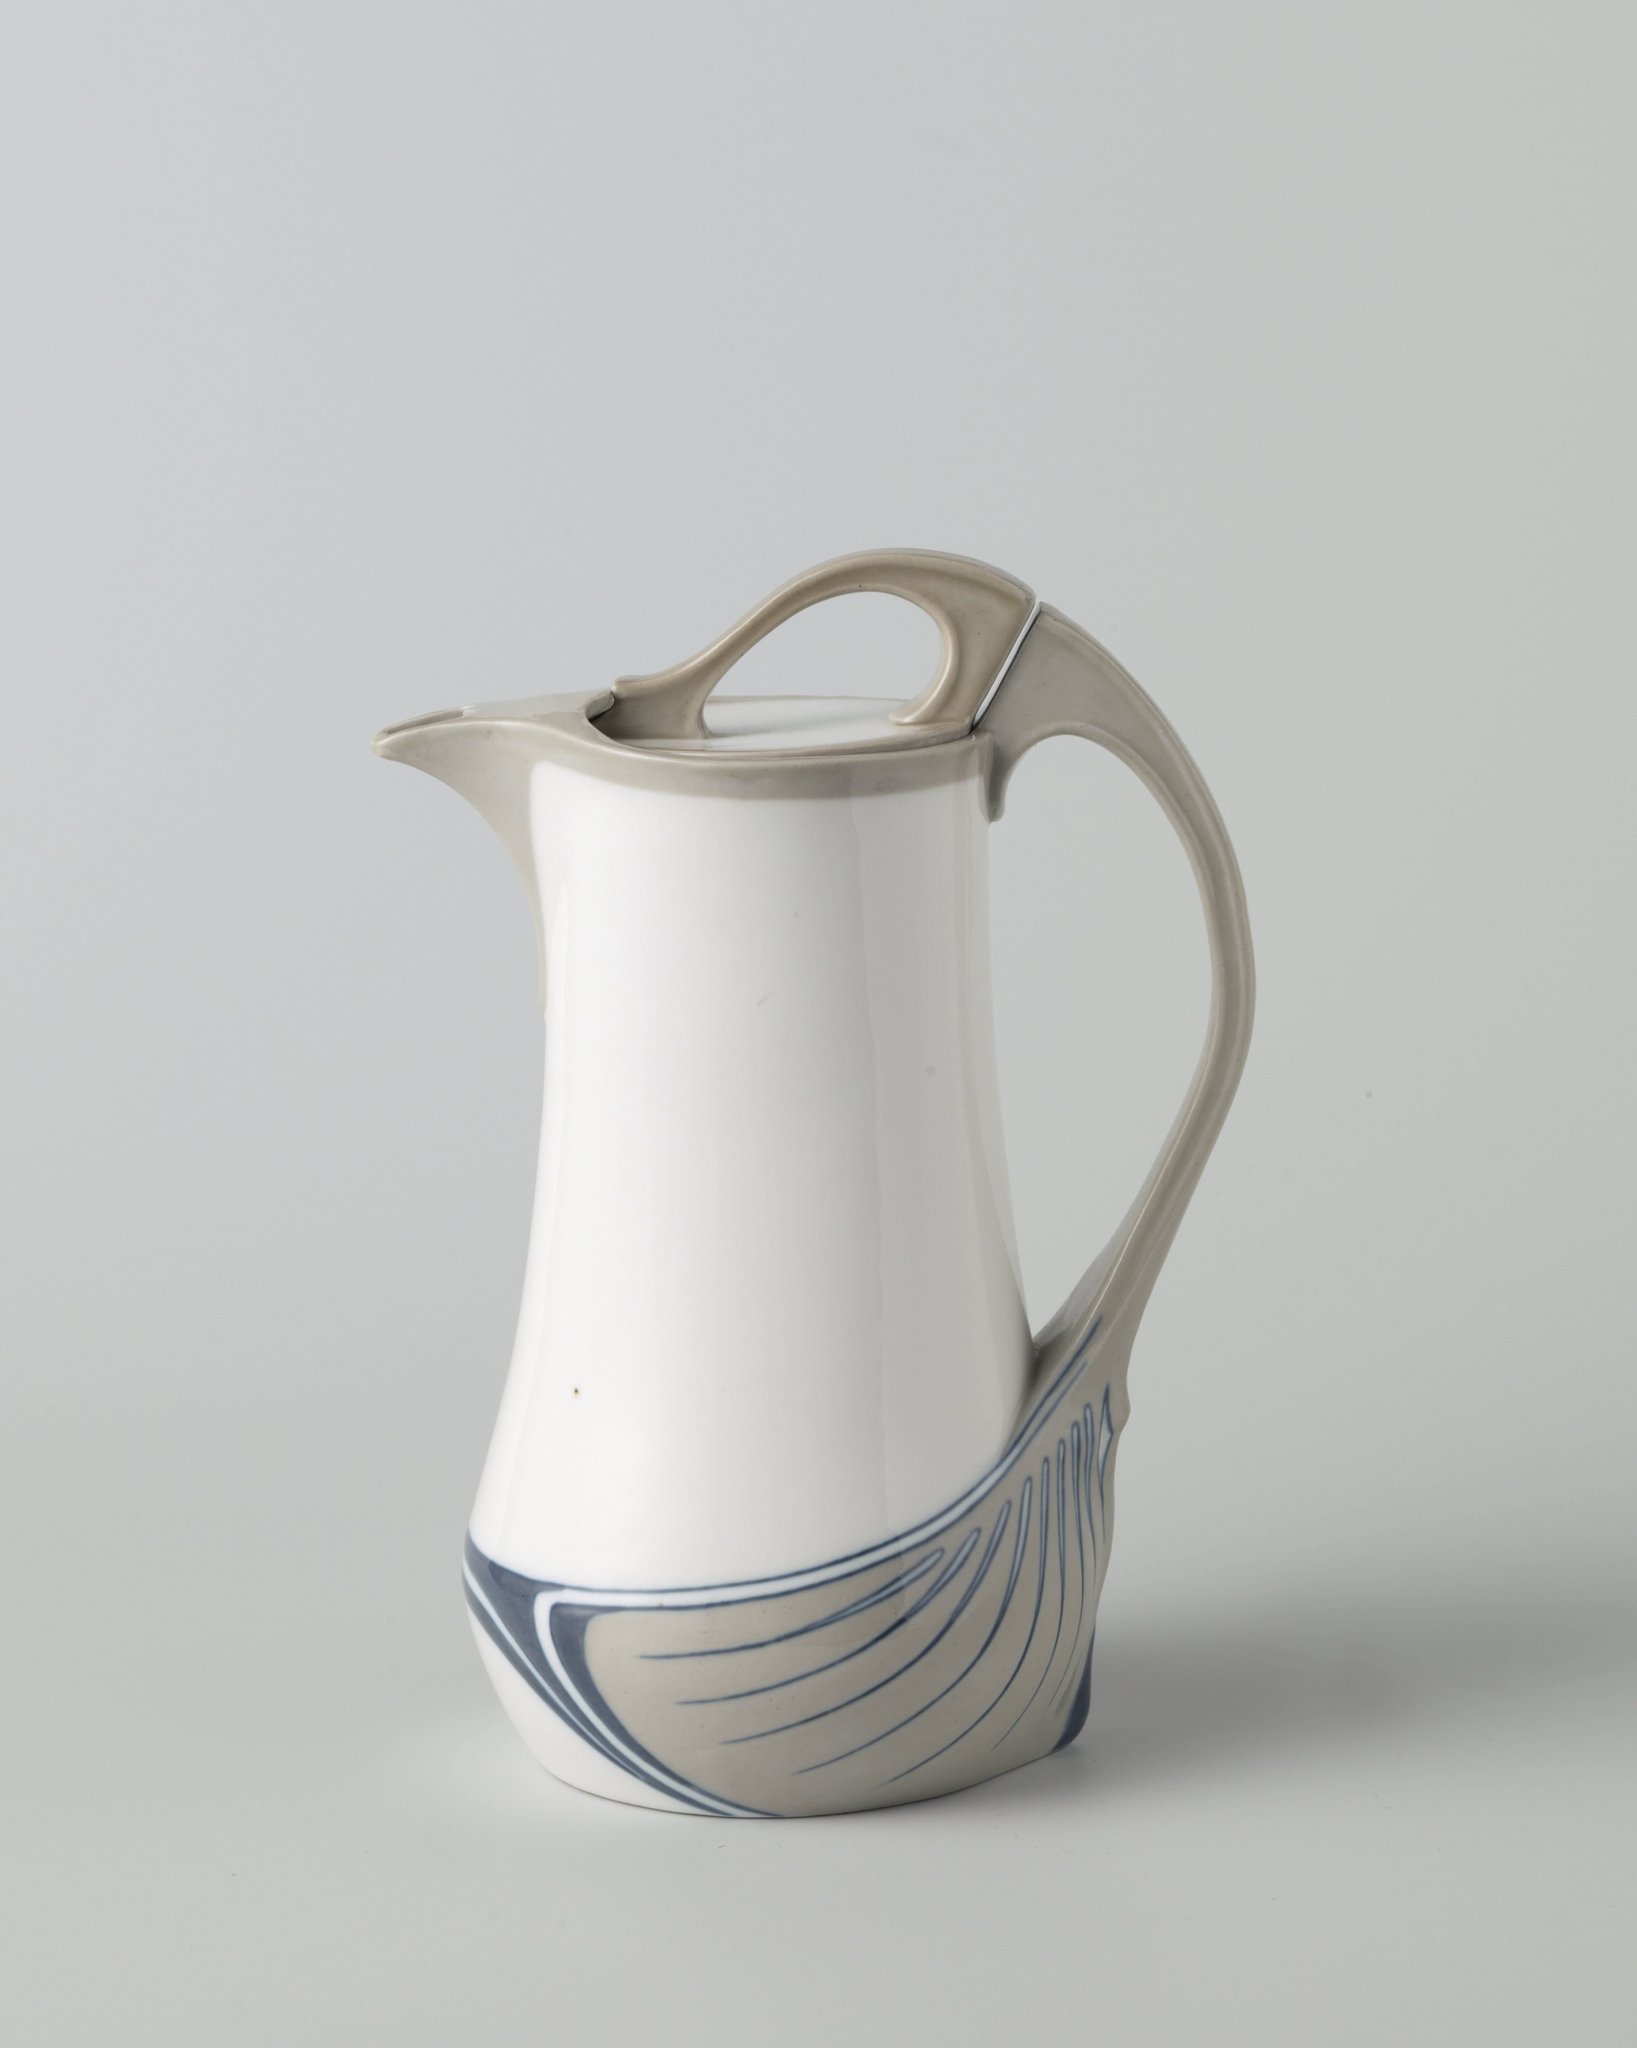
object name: coffee pot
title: Koffiekan met deksel uit het koffie- en theeservies 'Saxonia'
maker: otto eduard voigt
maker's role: keramiekontwerper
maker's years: 1870-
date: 1904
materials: porcelain, chemical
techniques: painted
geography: meissen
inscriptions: model number: ‘U 124’, factory mark, mark: ‘87’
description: Parts of a tea and coffee service. Porcelain. Meissen, Königlich Sächsische Porzellanmanufaktur, 1904, designed by Otto Eduard Voigt.